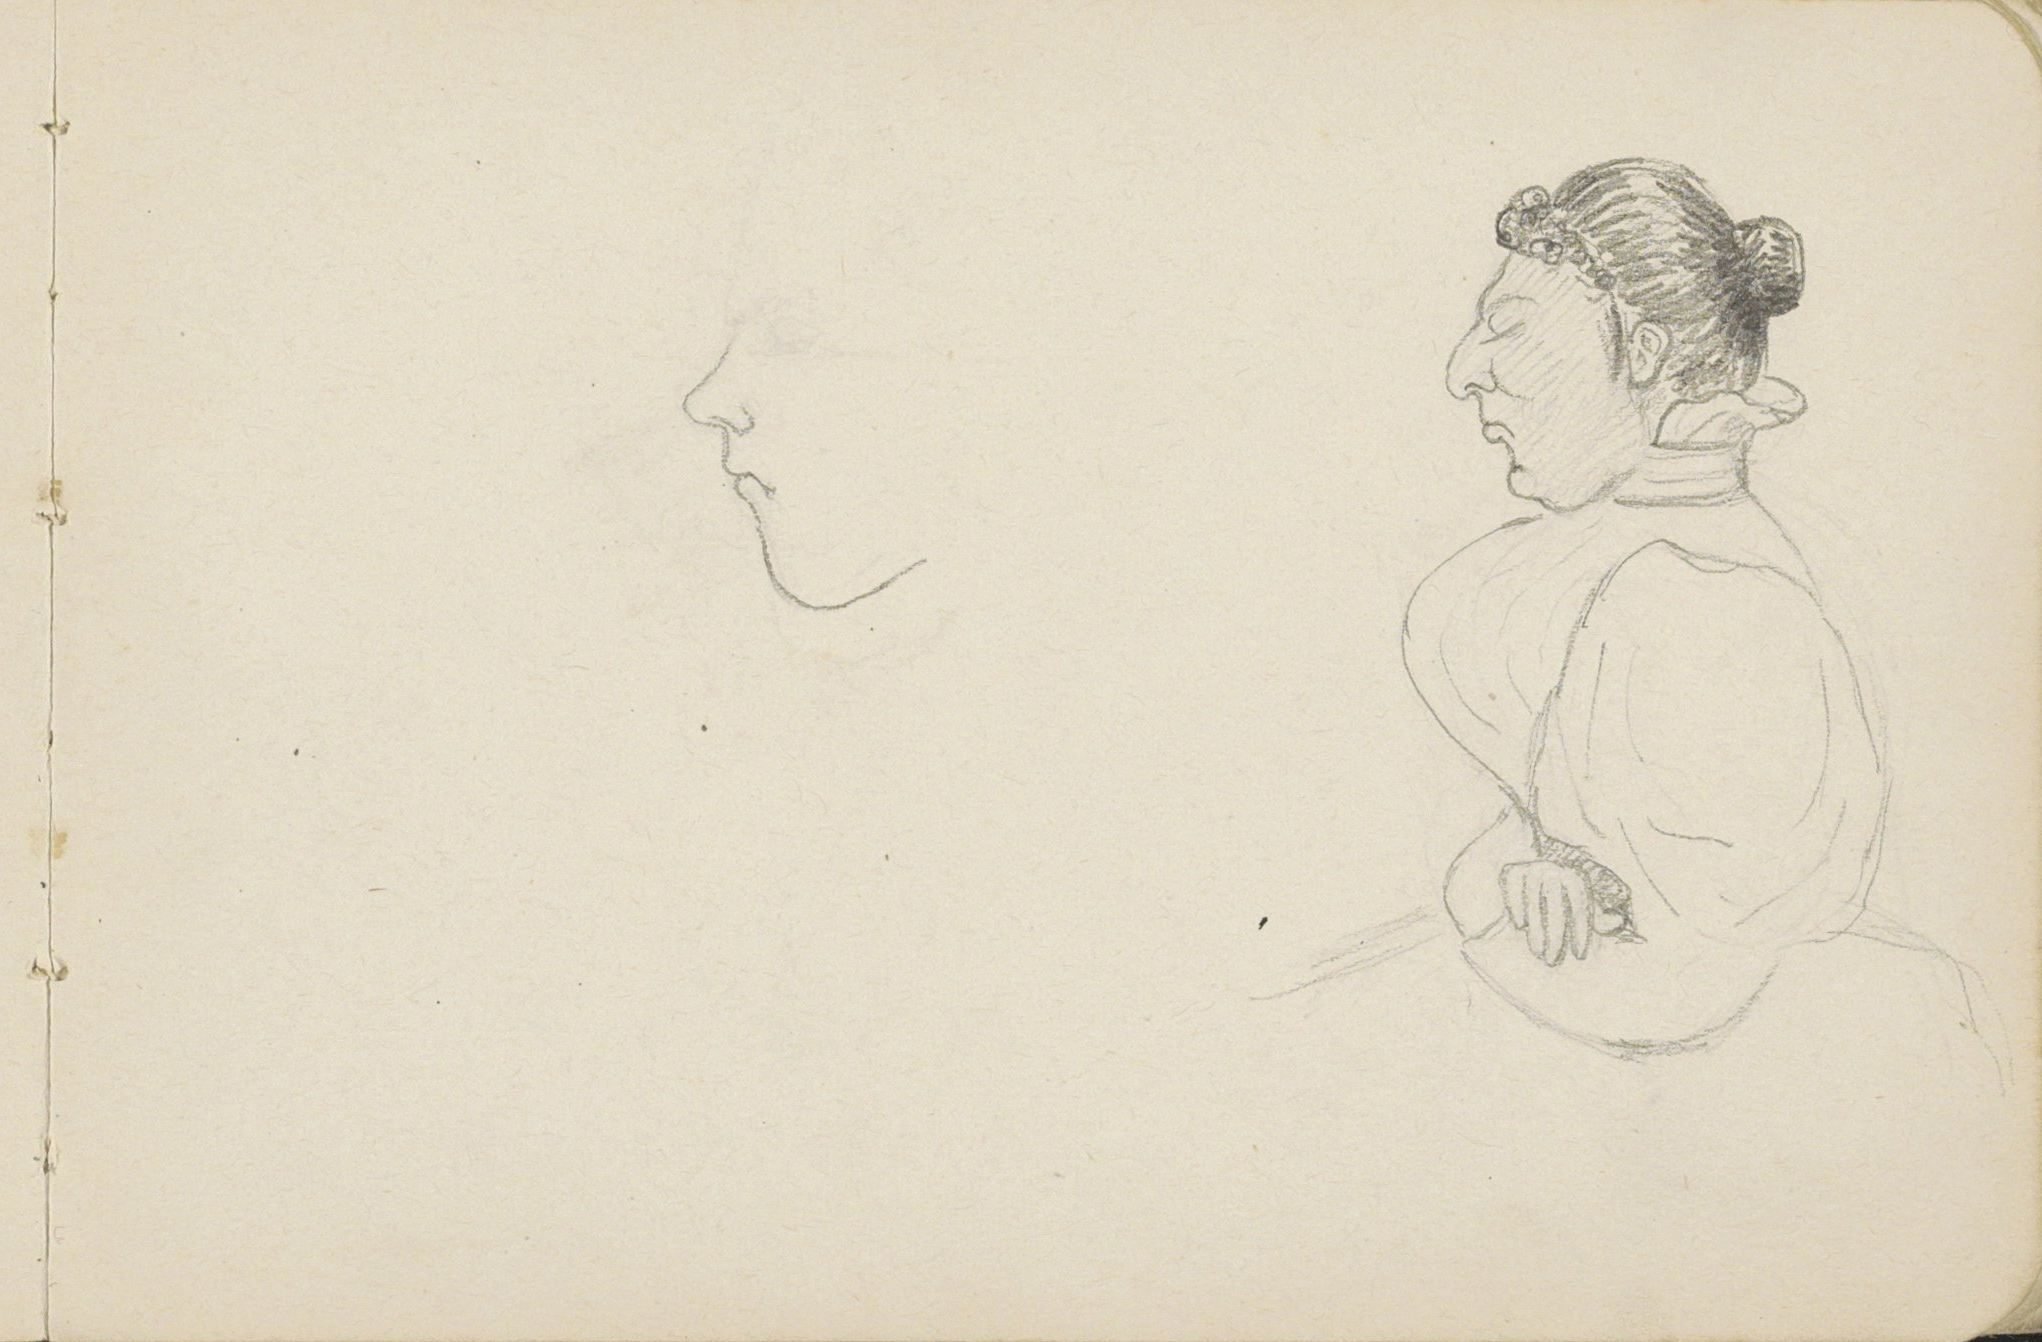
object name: sketchbook leaf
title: Zittende vrouw met een karikaturale kop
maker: julie de graag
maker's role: draughtsman, print maker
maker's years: 1877-1924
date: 1894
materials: paper, pencil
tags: arms crossed, sitting figure, adult woman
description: De vrouw heeft de armen over elkaar geslagen. Tevens een studie van haar mond en neus. Blad 3 recto uit een schetsboek met 35 bladen.